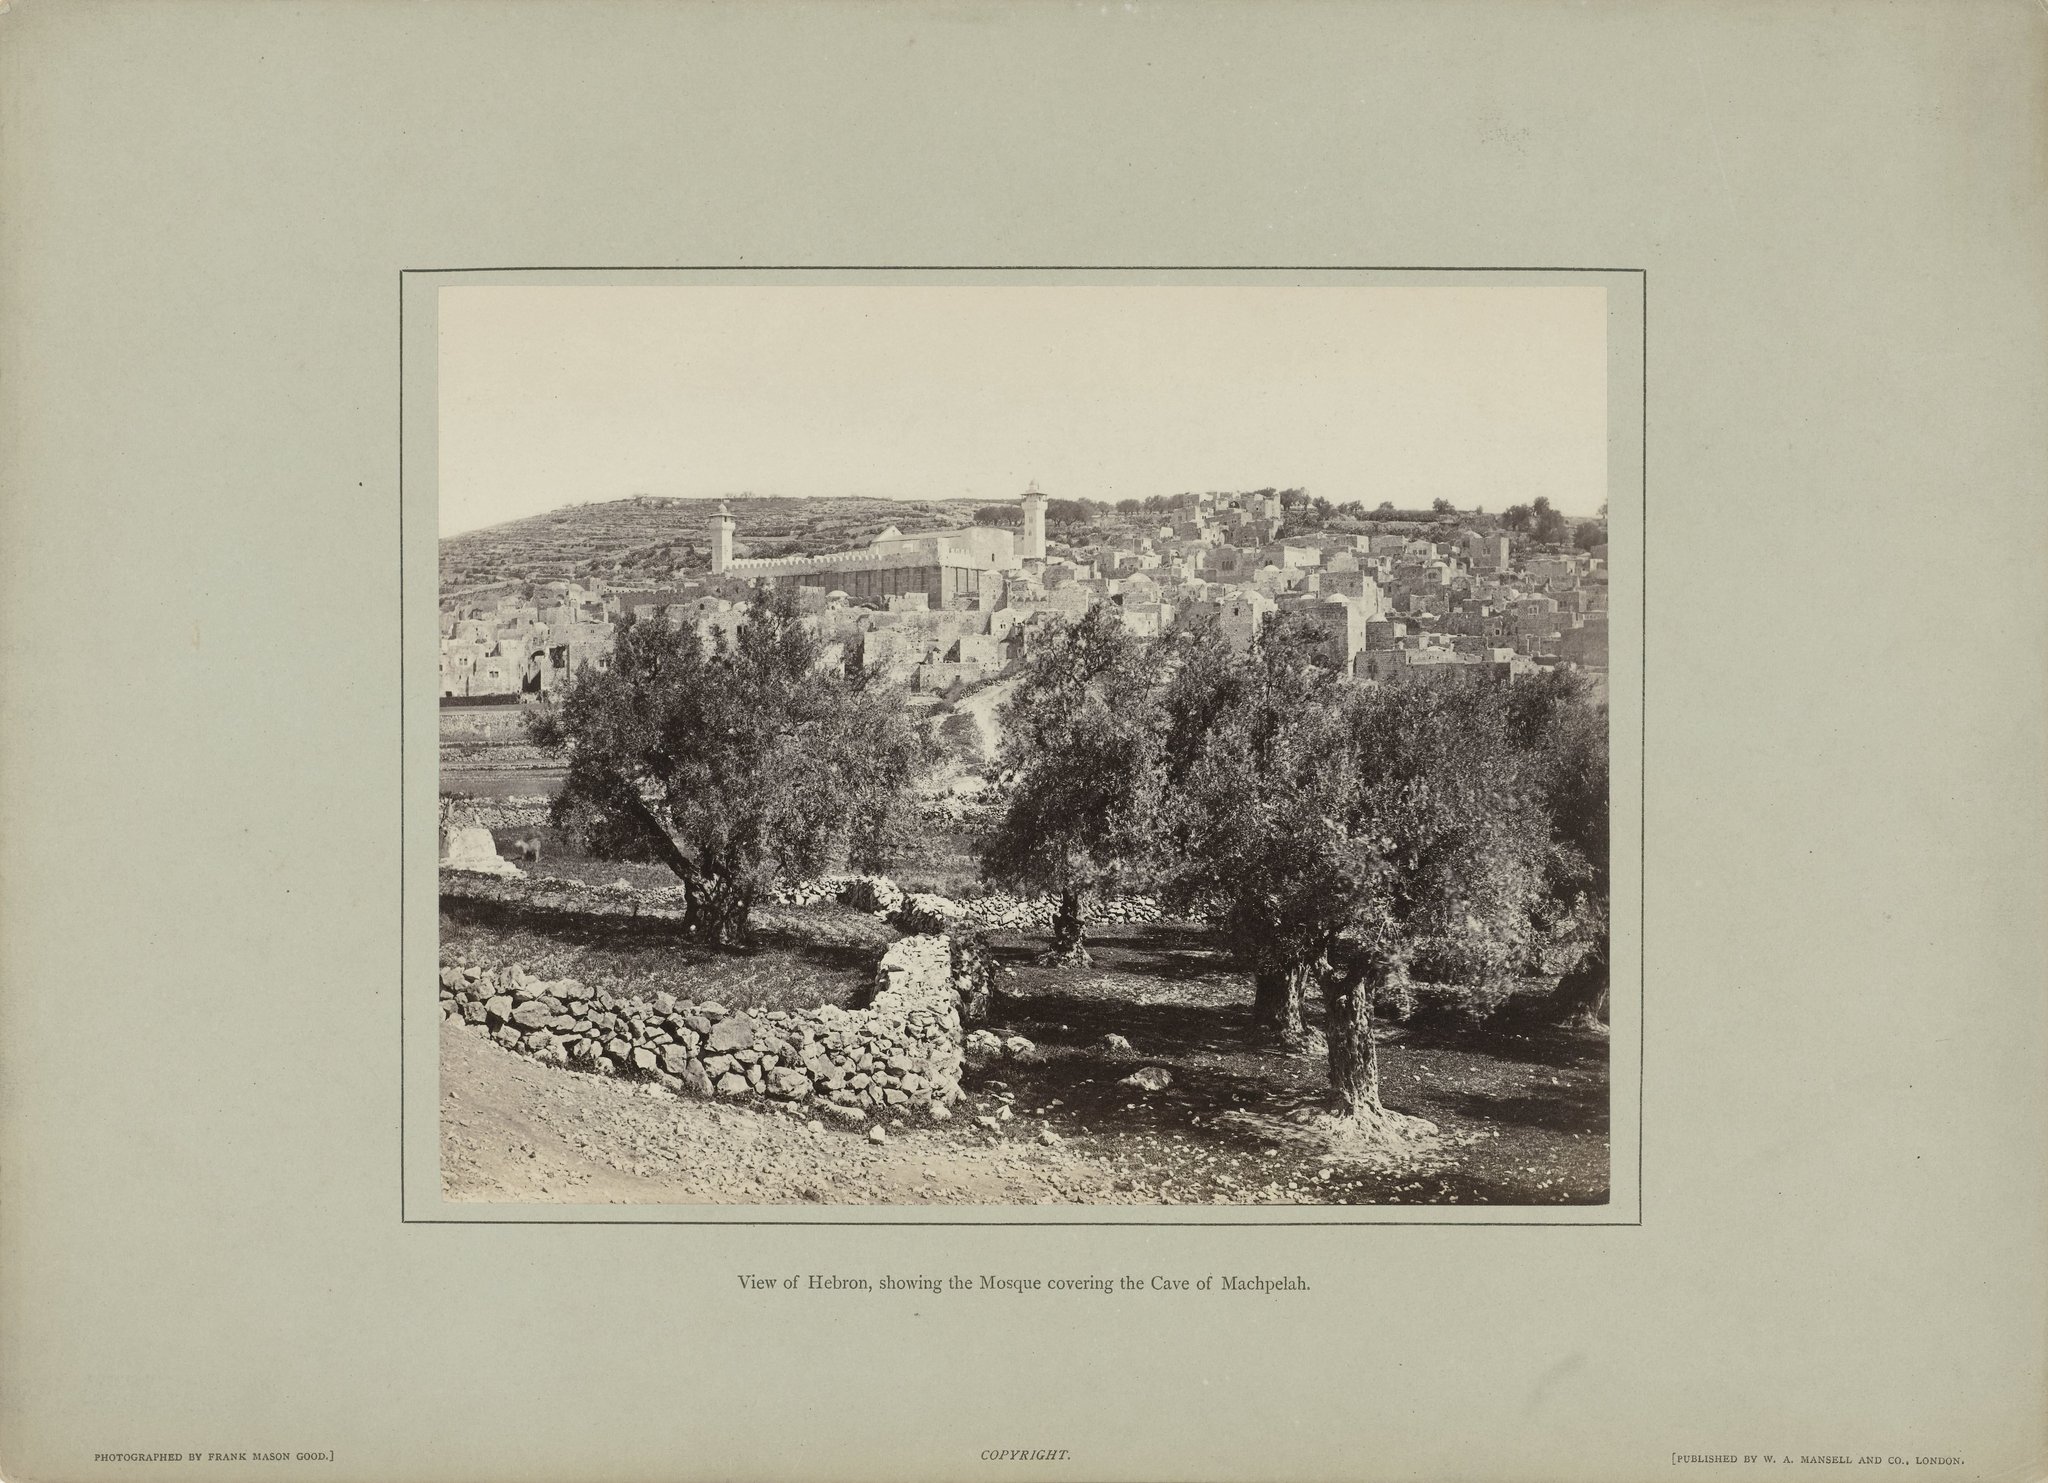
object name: photograph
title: Gezicht op Hebron, Palestina, in de verte de tombe van de Patriarchen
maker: frank mason good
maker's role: publisher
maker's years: 1839-1928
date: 1864-1869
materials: cardboard, paper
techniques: albumen print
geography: london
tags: city-view in general; 'veduta'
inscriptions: copyright notice: ‘COPYRIGHT.’